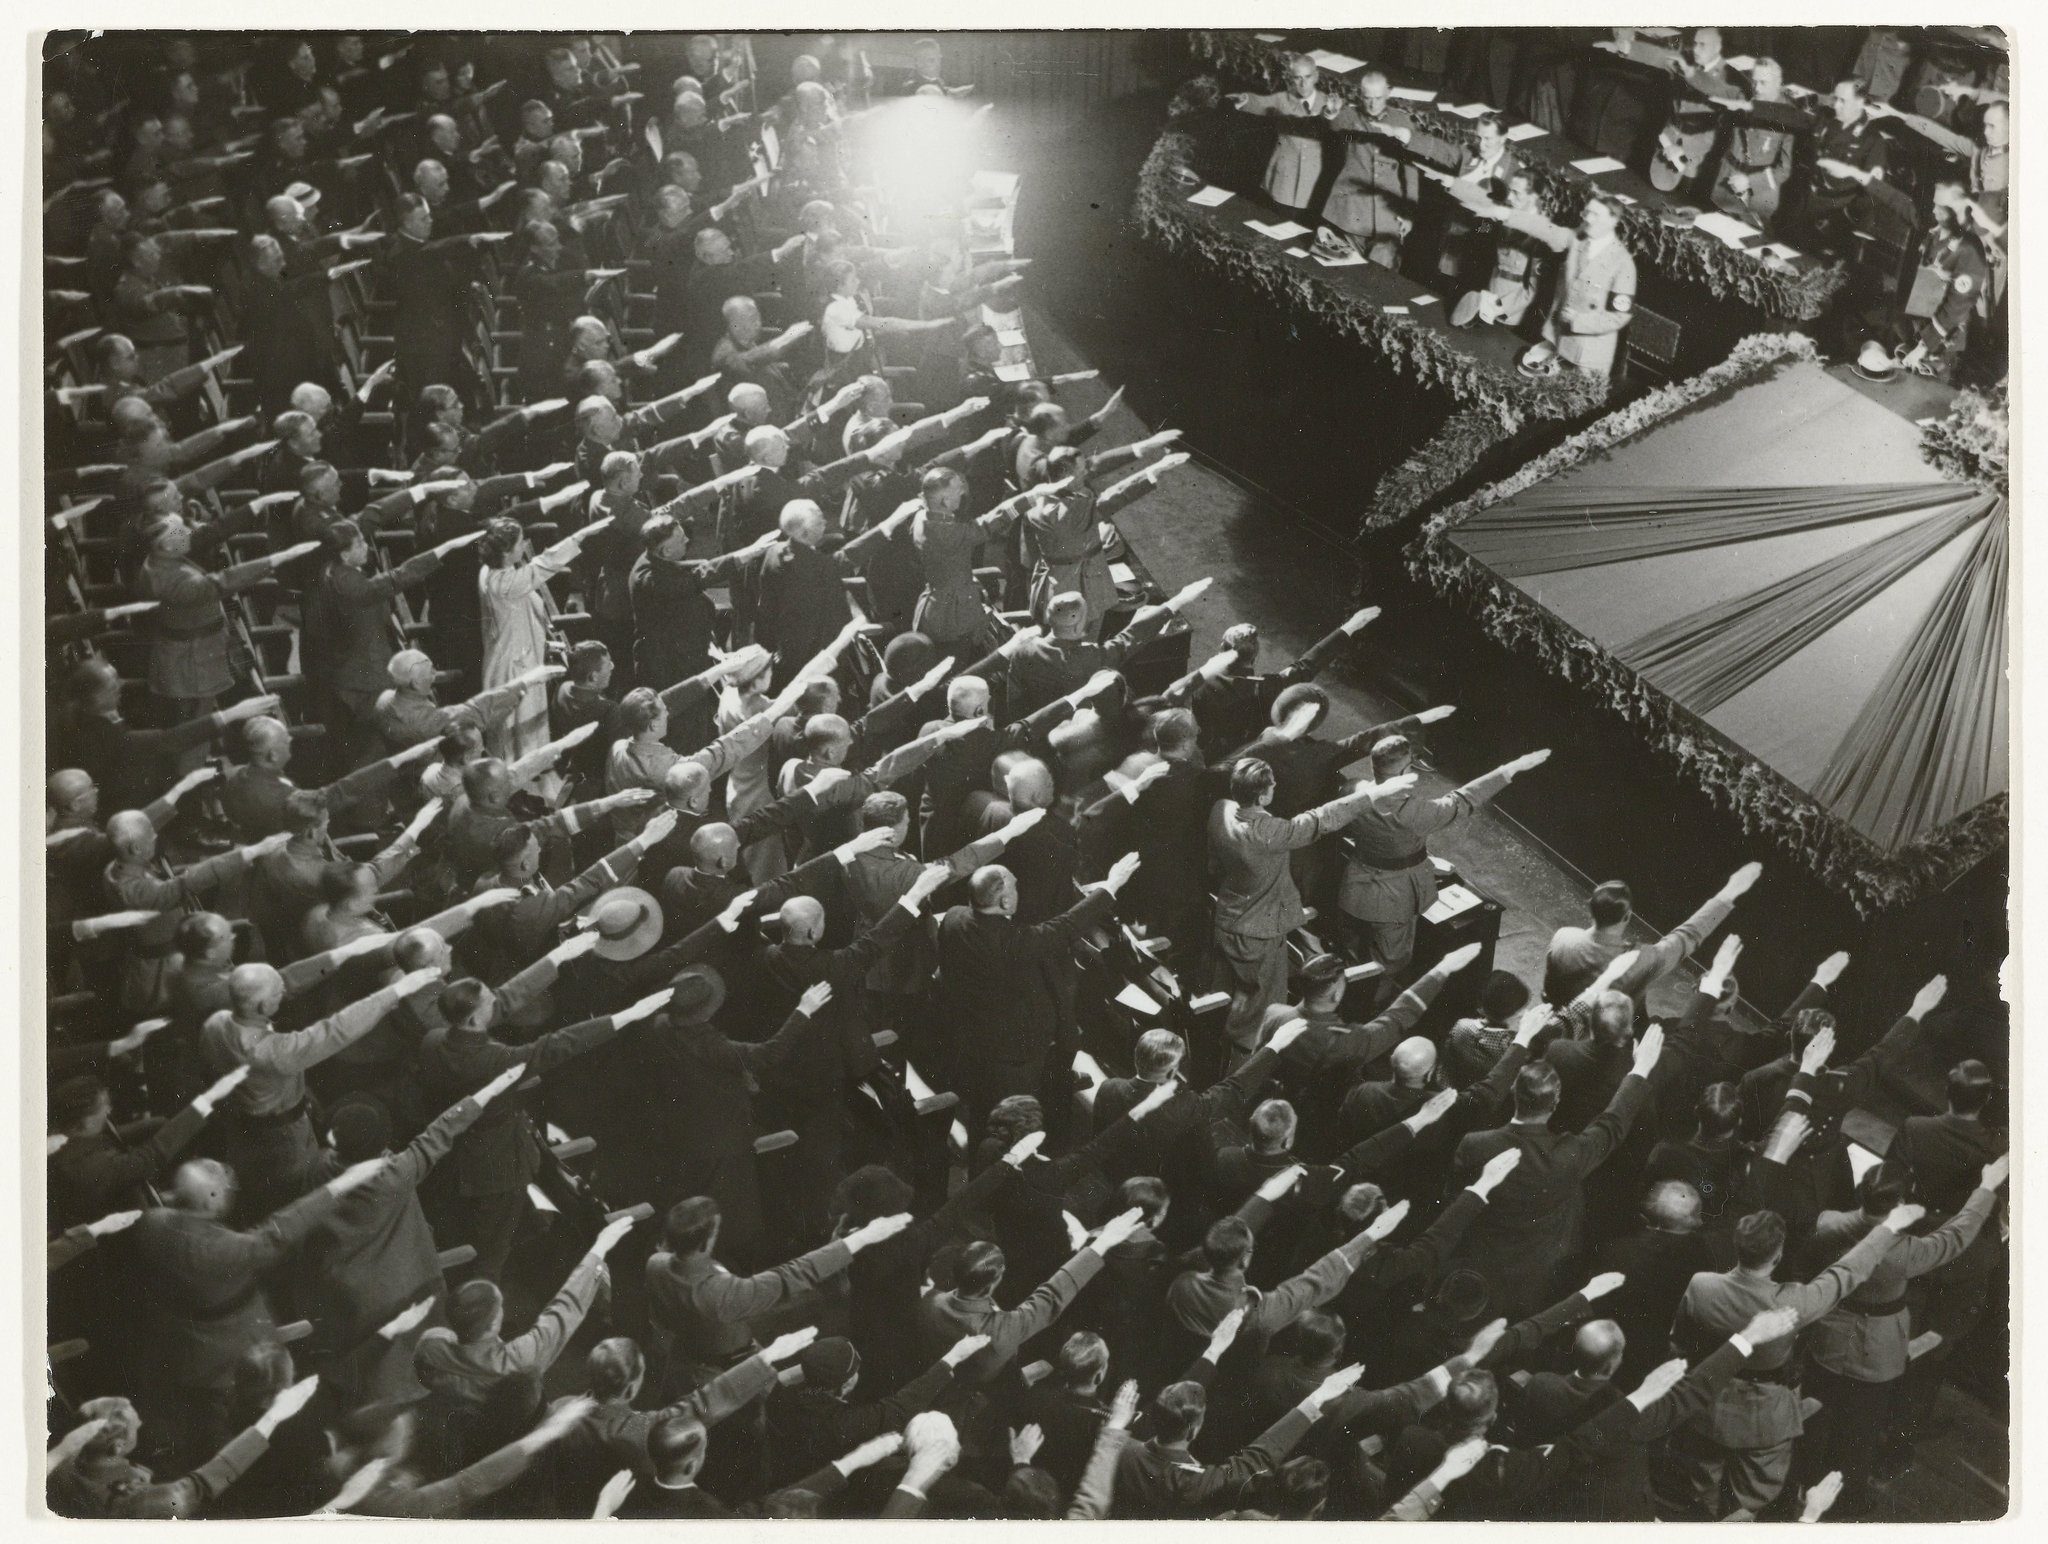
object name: photograph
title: Winterhulp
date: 1935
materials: photographic support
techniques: photography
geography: berlin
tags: berlin, politician, adolf hitler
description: In de Krollopera in Berlijn werd de start van het werk voor de Winterhulp feestelijk geopend door A. Hitler. de aanwezigen brengen de Hitlergroet en zingen het volkslied. In dit gebouw kondigde Hitler in 1939 het uitbreken van de 2e wereldoorlog aan.